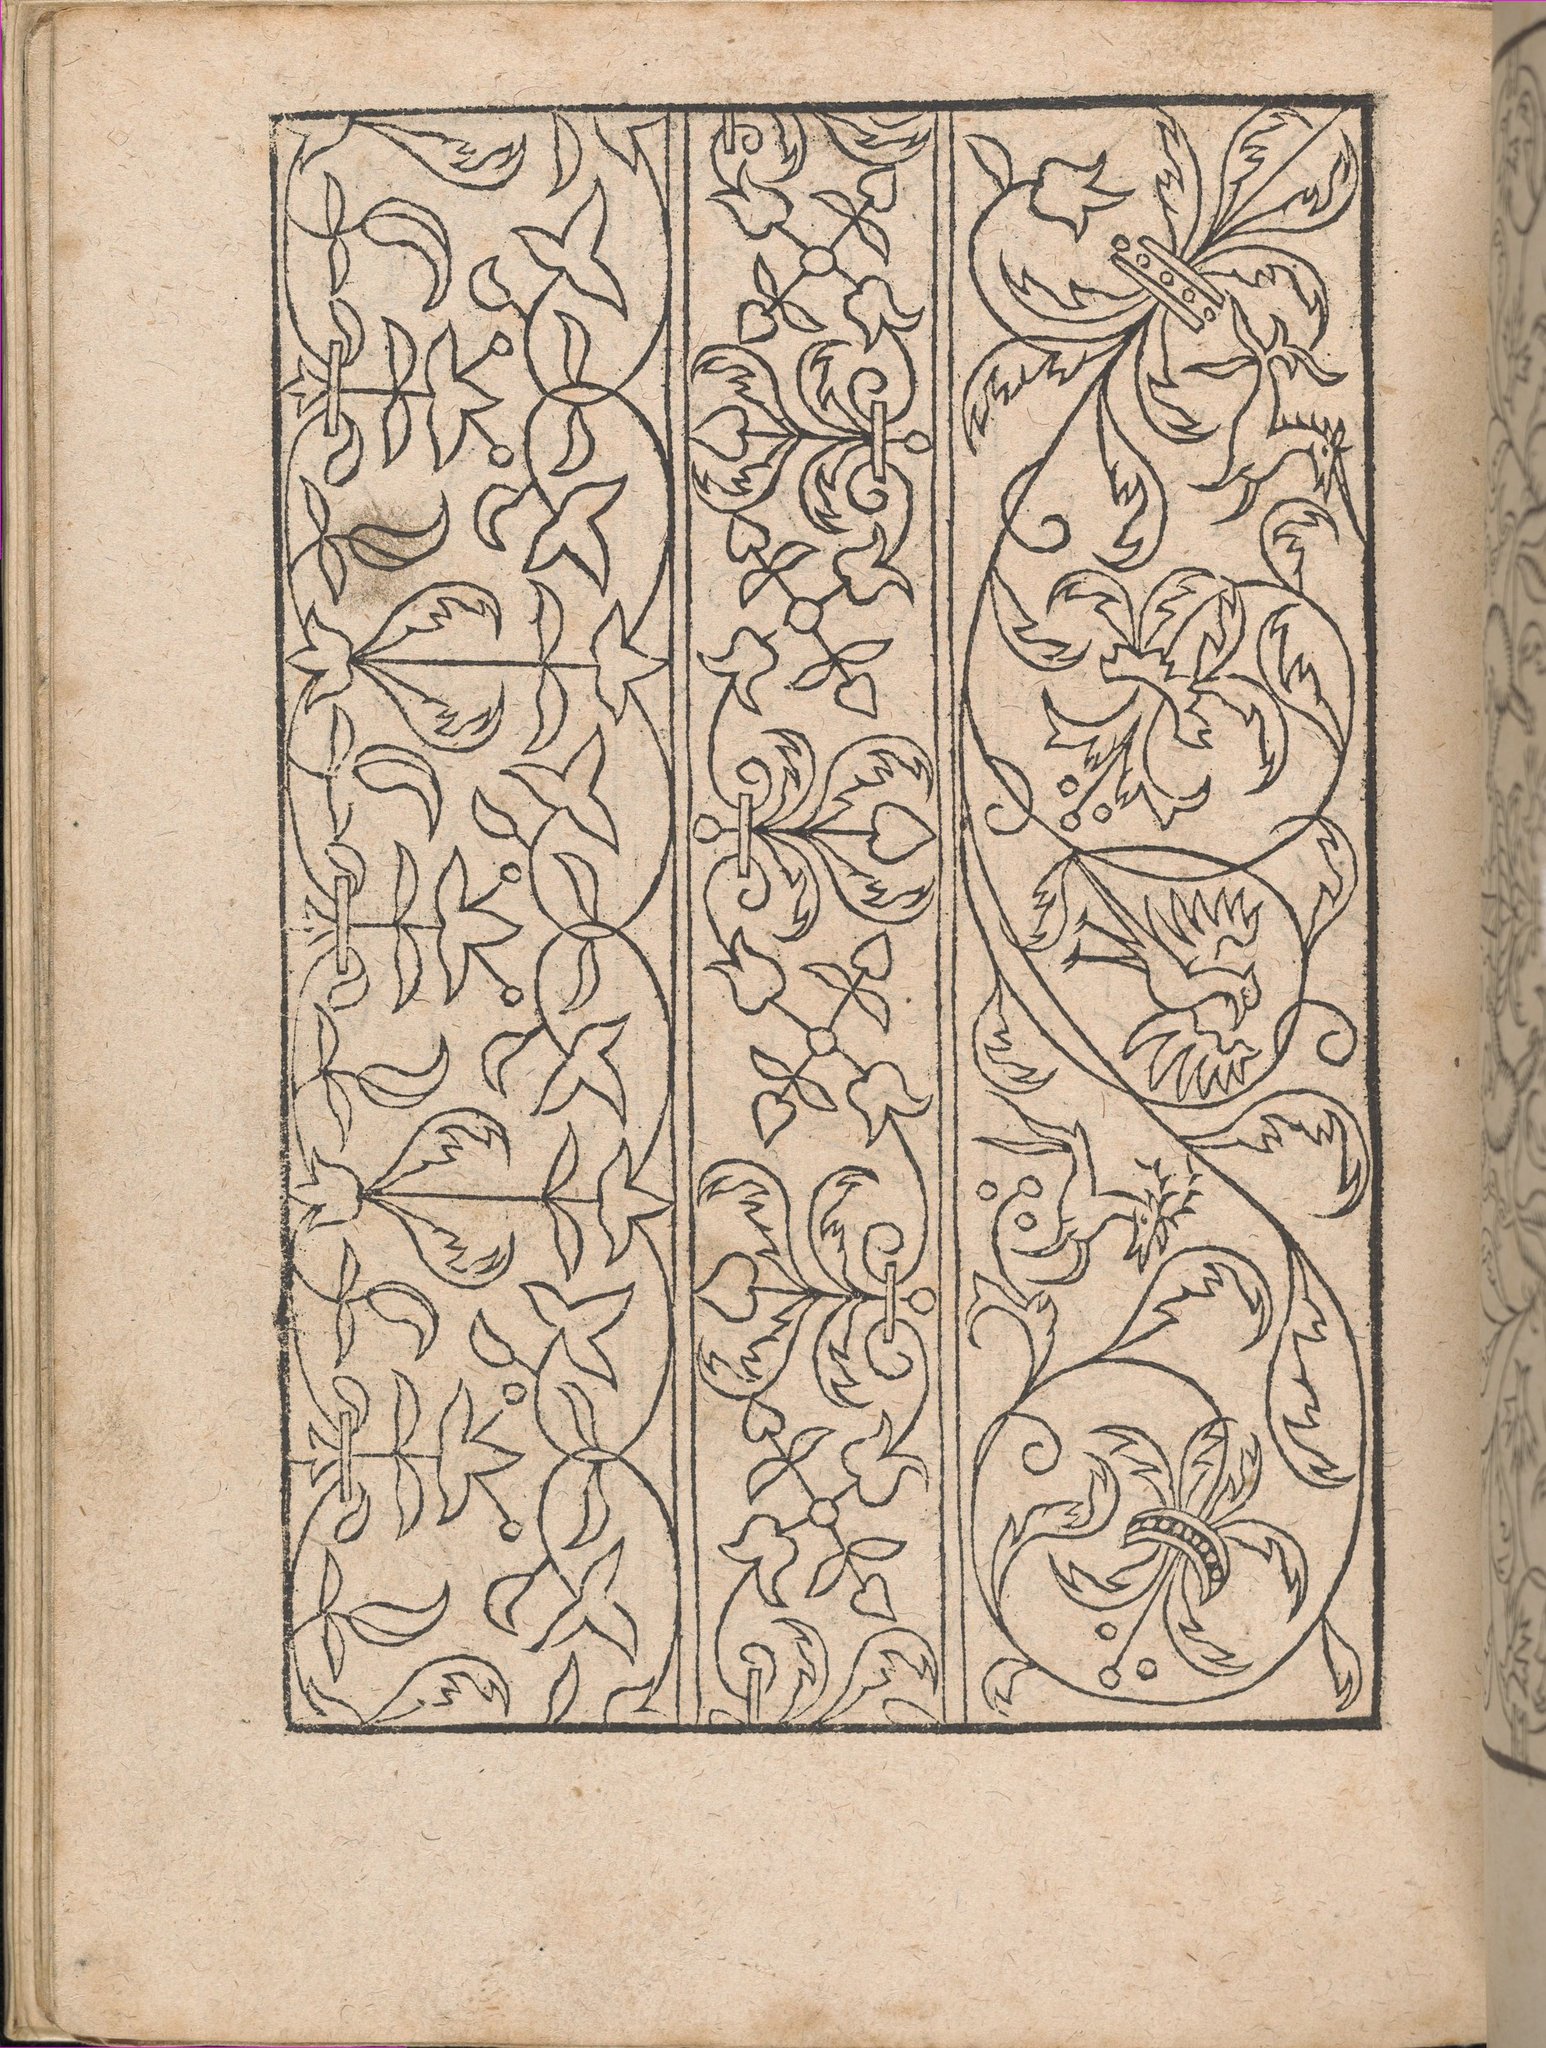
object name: book print ornament architecture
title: New Modelbüch allen Nägerin u. Sydenstickern (Page 16v)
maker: hans hoffman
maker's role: designer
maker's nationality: german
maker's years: 1556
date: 1556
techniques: woodcut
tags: birds